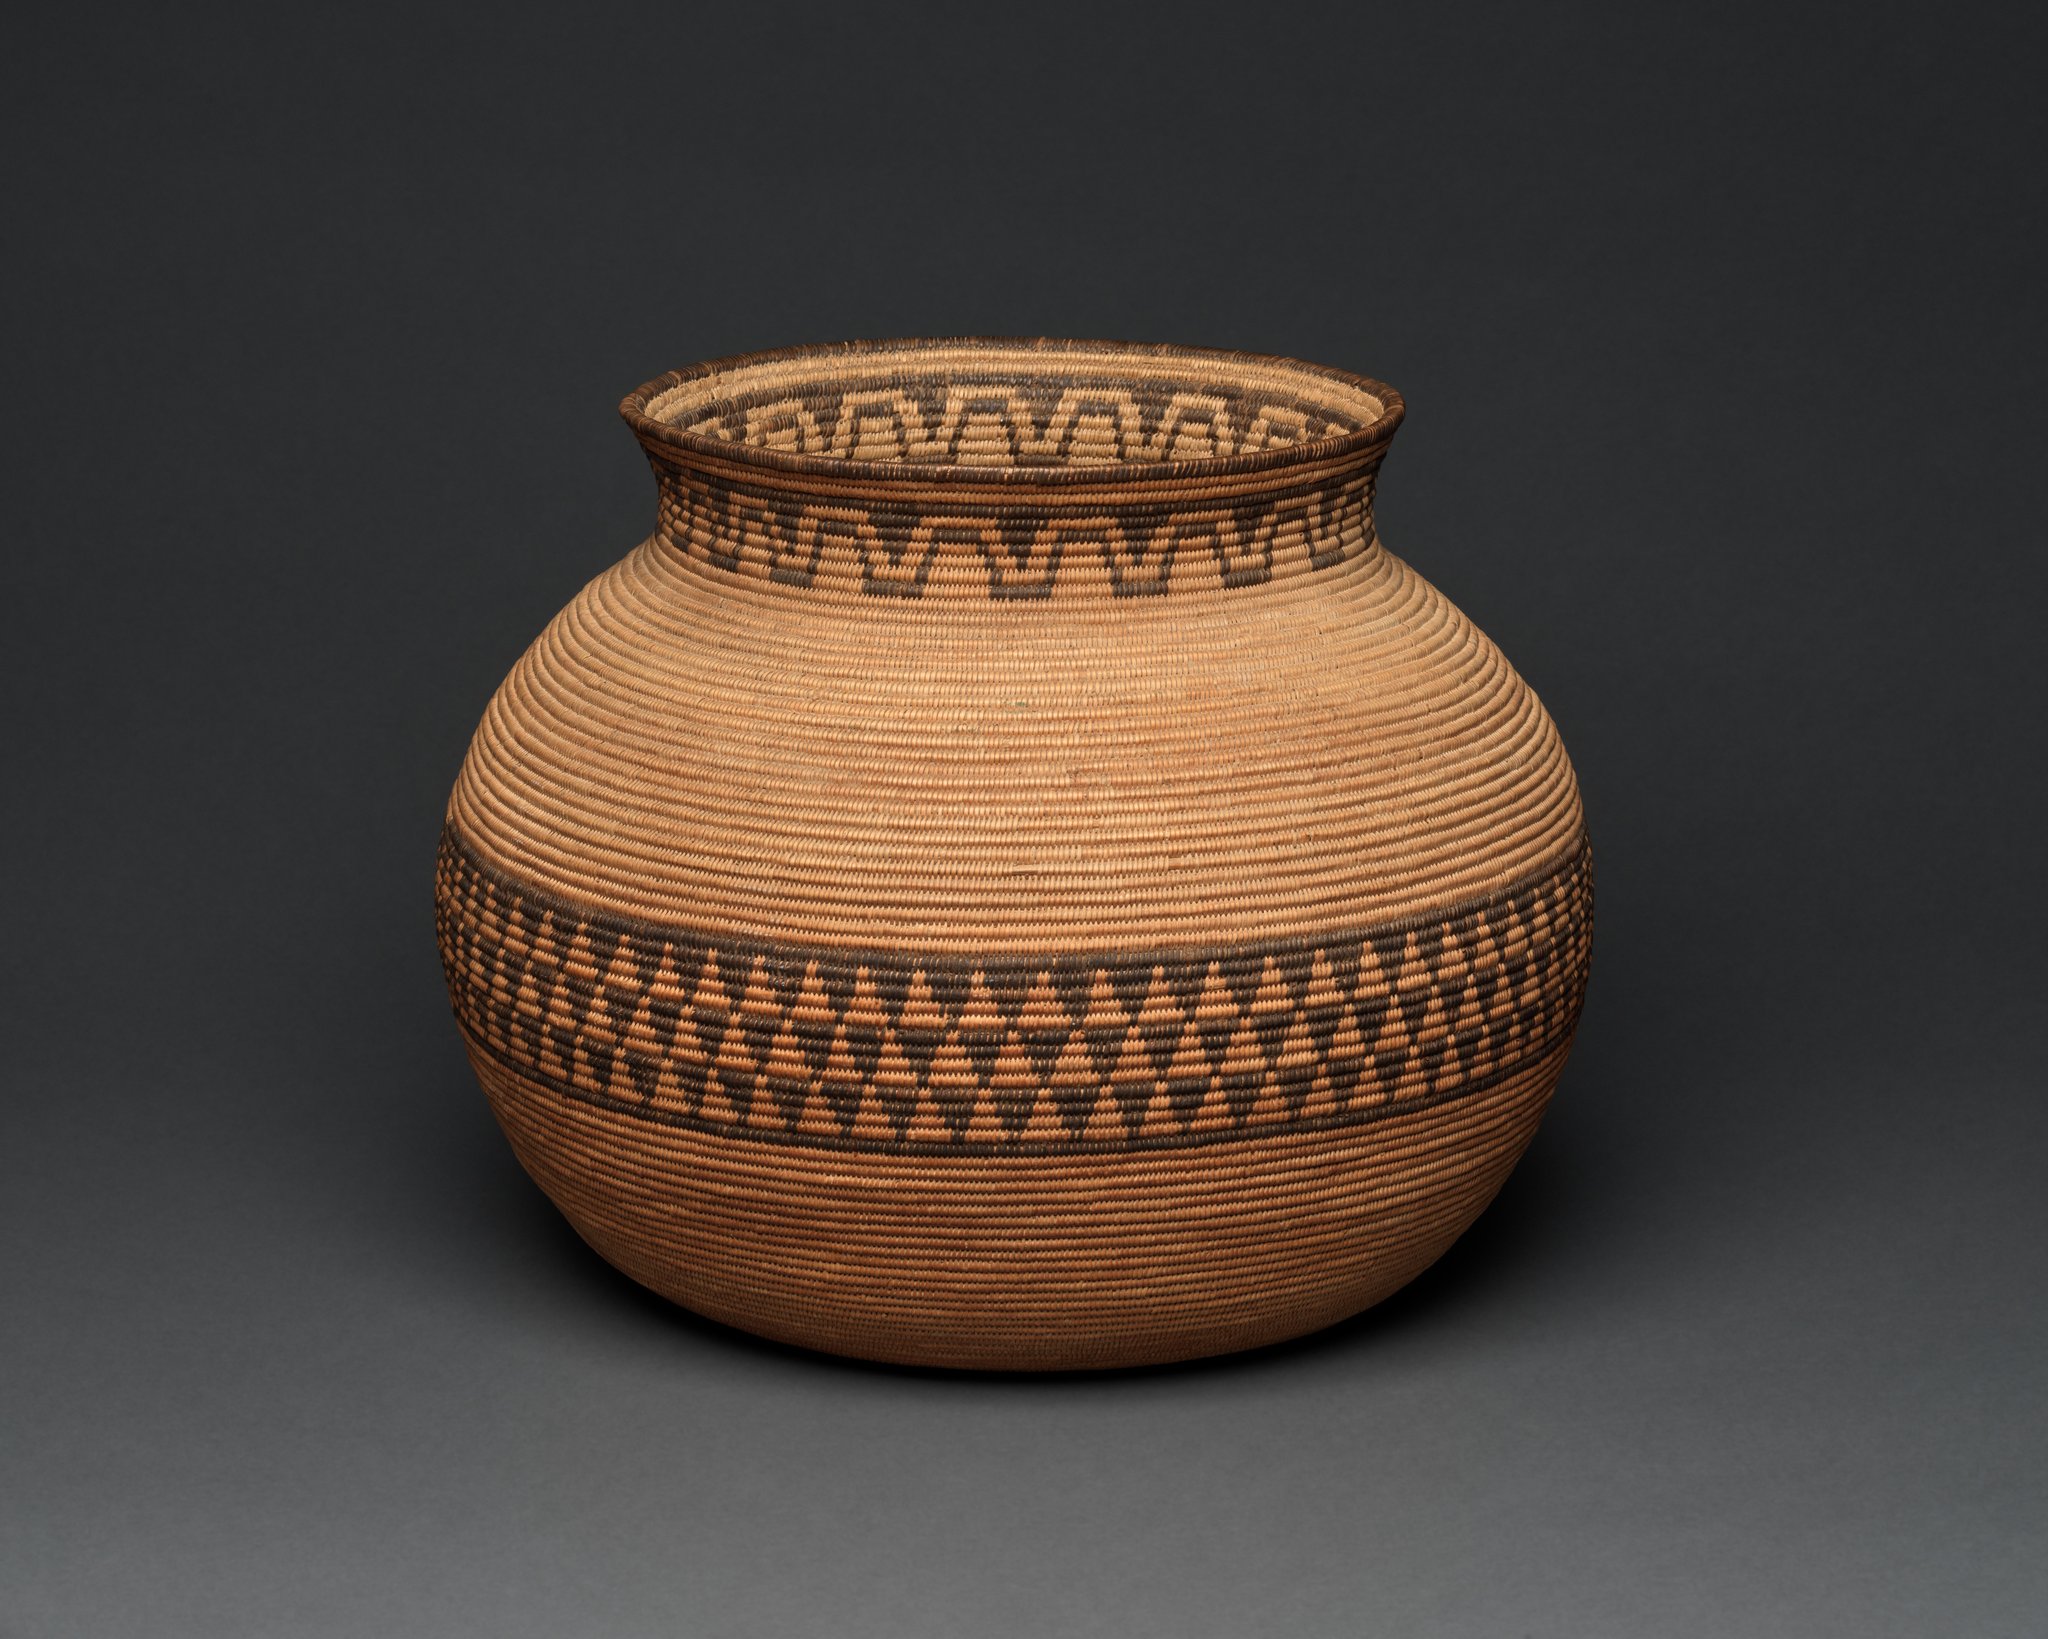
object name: basket jar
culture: chemehuevi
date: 1885